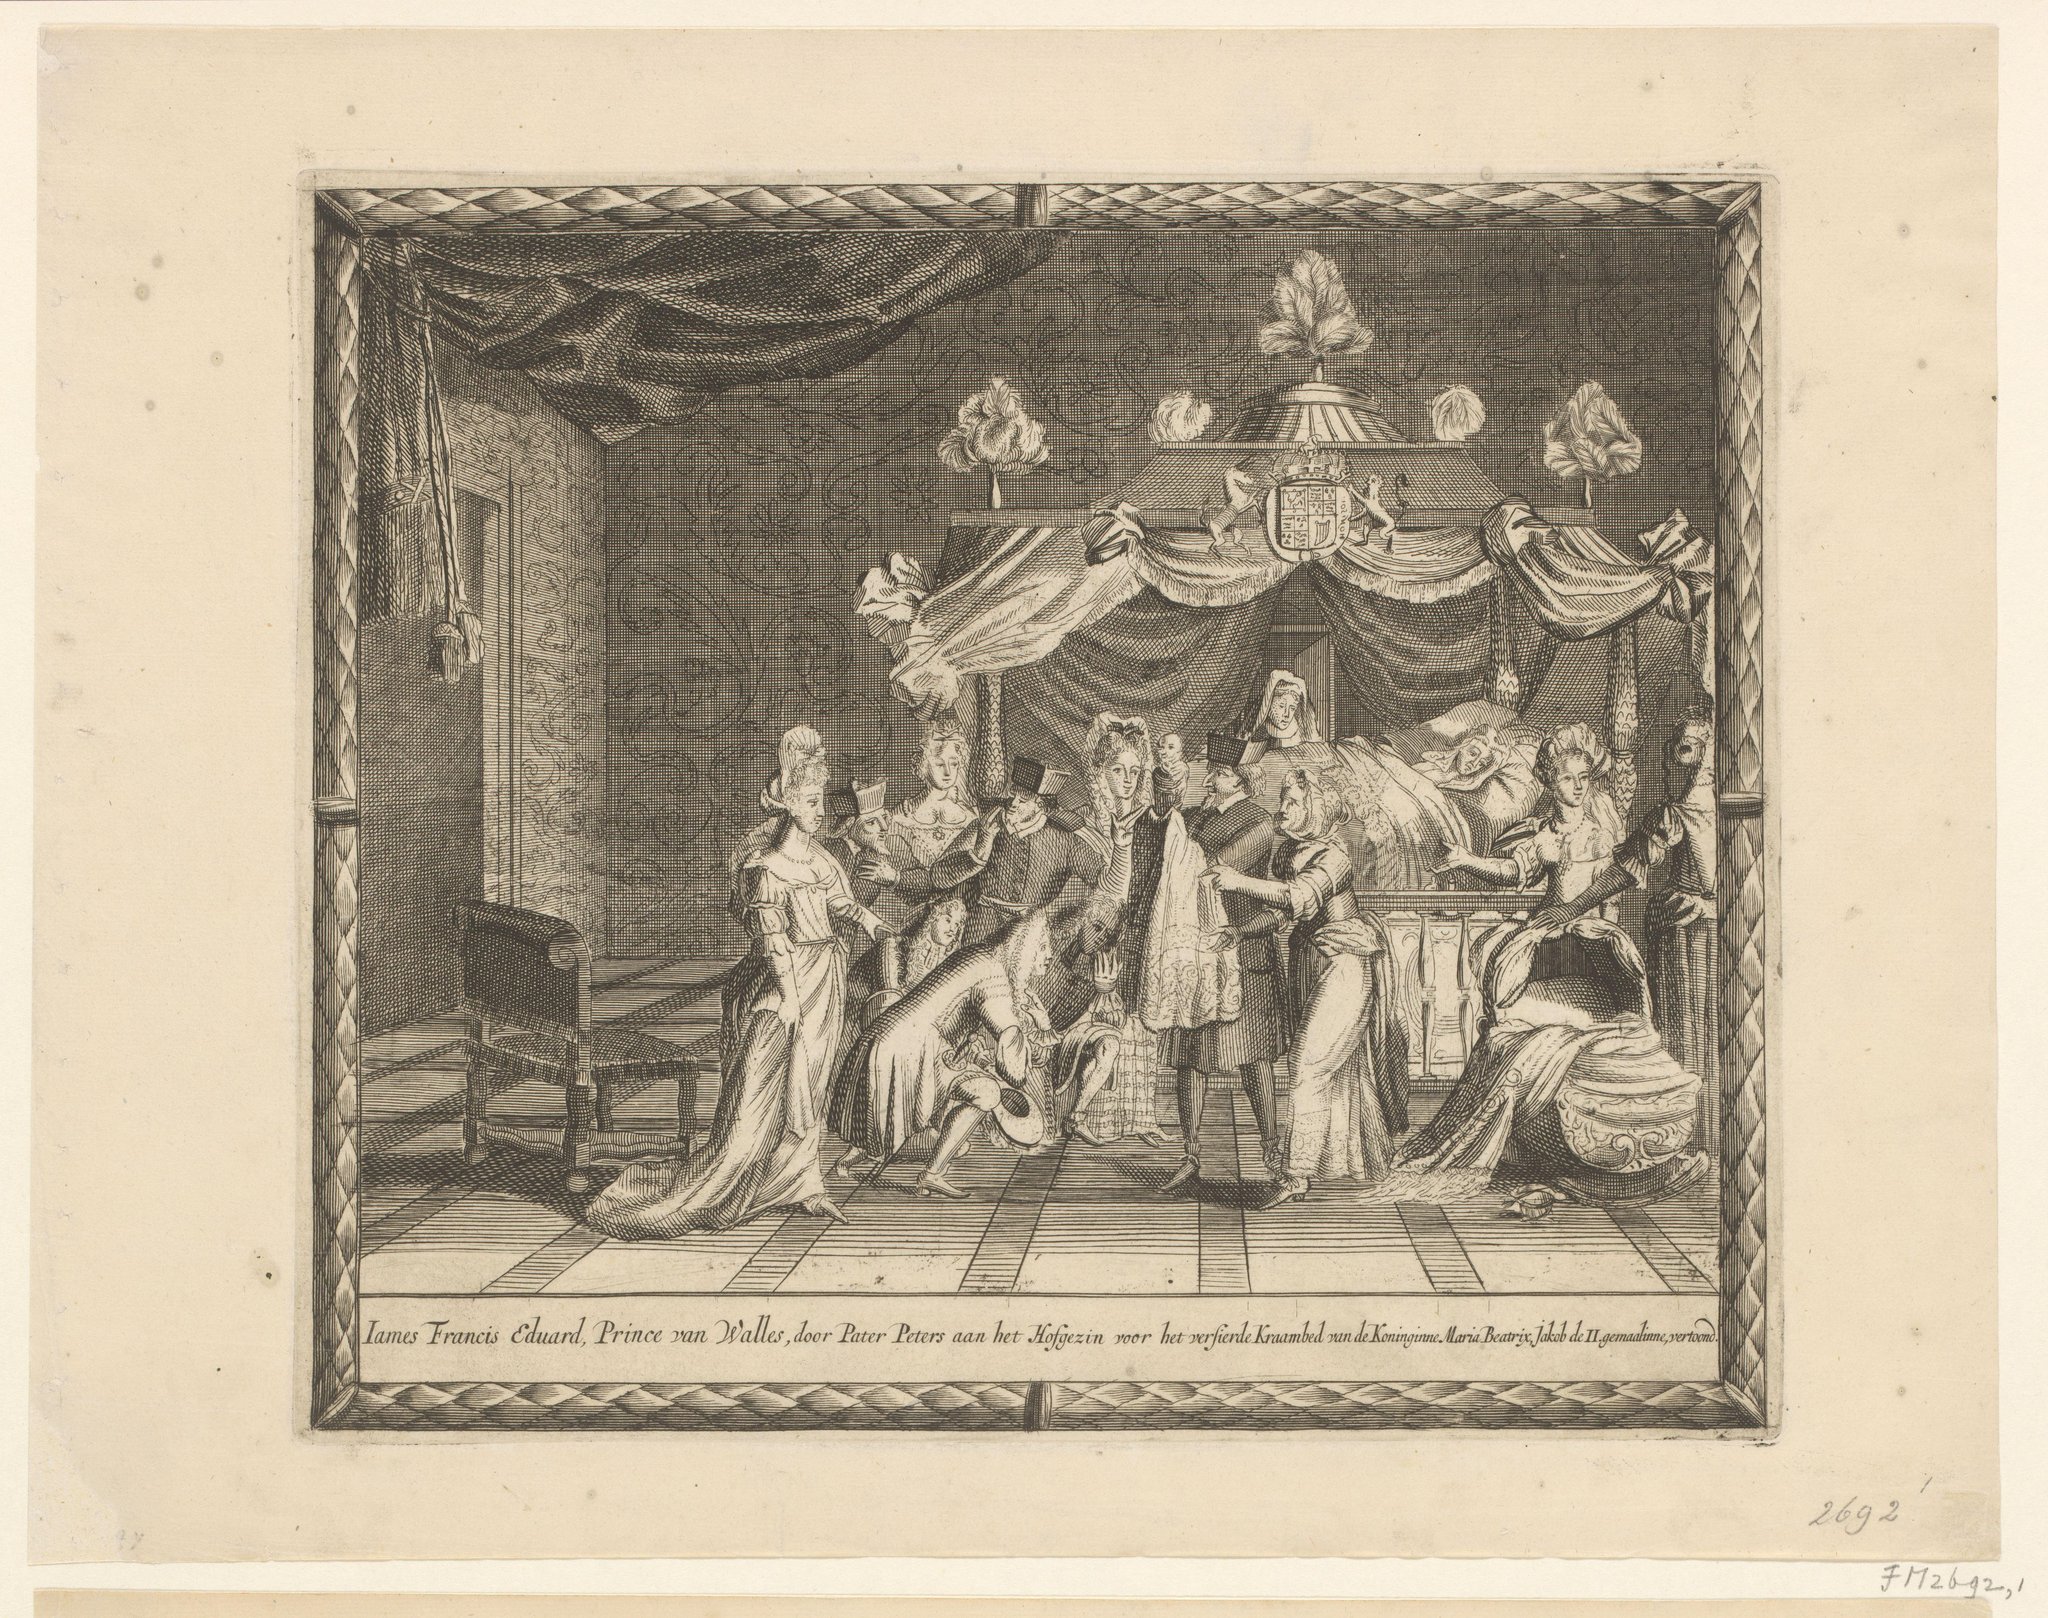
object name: print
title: De geboorte van Jacobus Frans Eduard, prins van Wales, 1688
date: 1691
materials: paper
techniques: engraving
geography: northern netherlands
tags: paris, london, rome, the new-born child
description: De geboorte van Jacobus Frans Eduard, prins van Wales, 10 juni 1688. Staande voor het kraambed van koningin Maria van Modena houdt Pater Peters het pasgeboren kind omhoog. Plaat 1 in een serie van 20 platen over de Glorious Revolution in Engeland in de jaren 1688-1691.